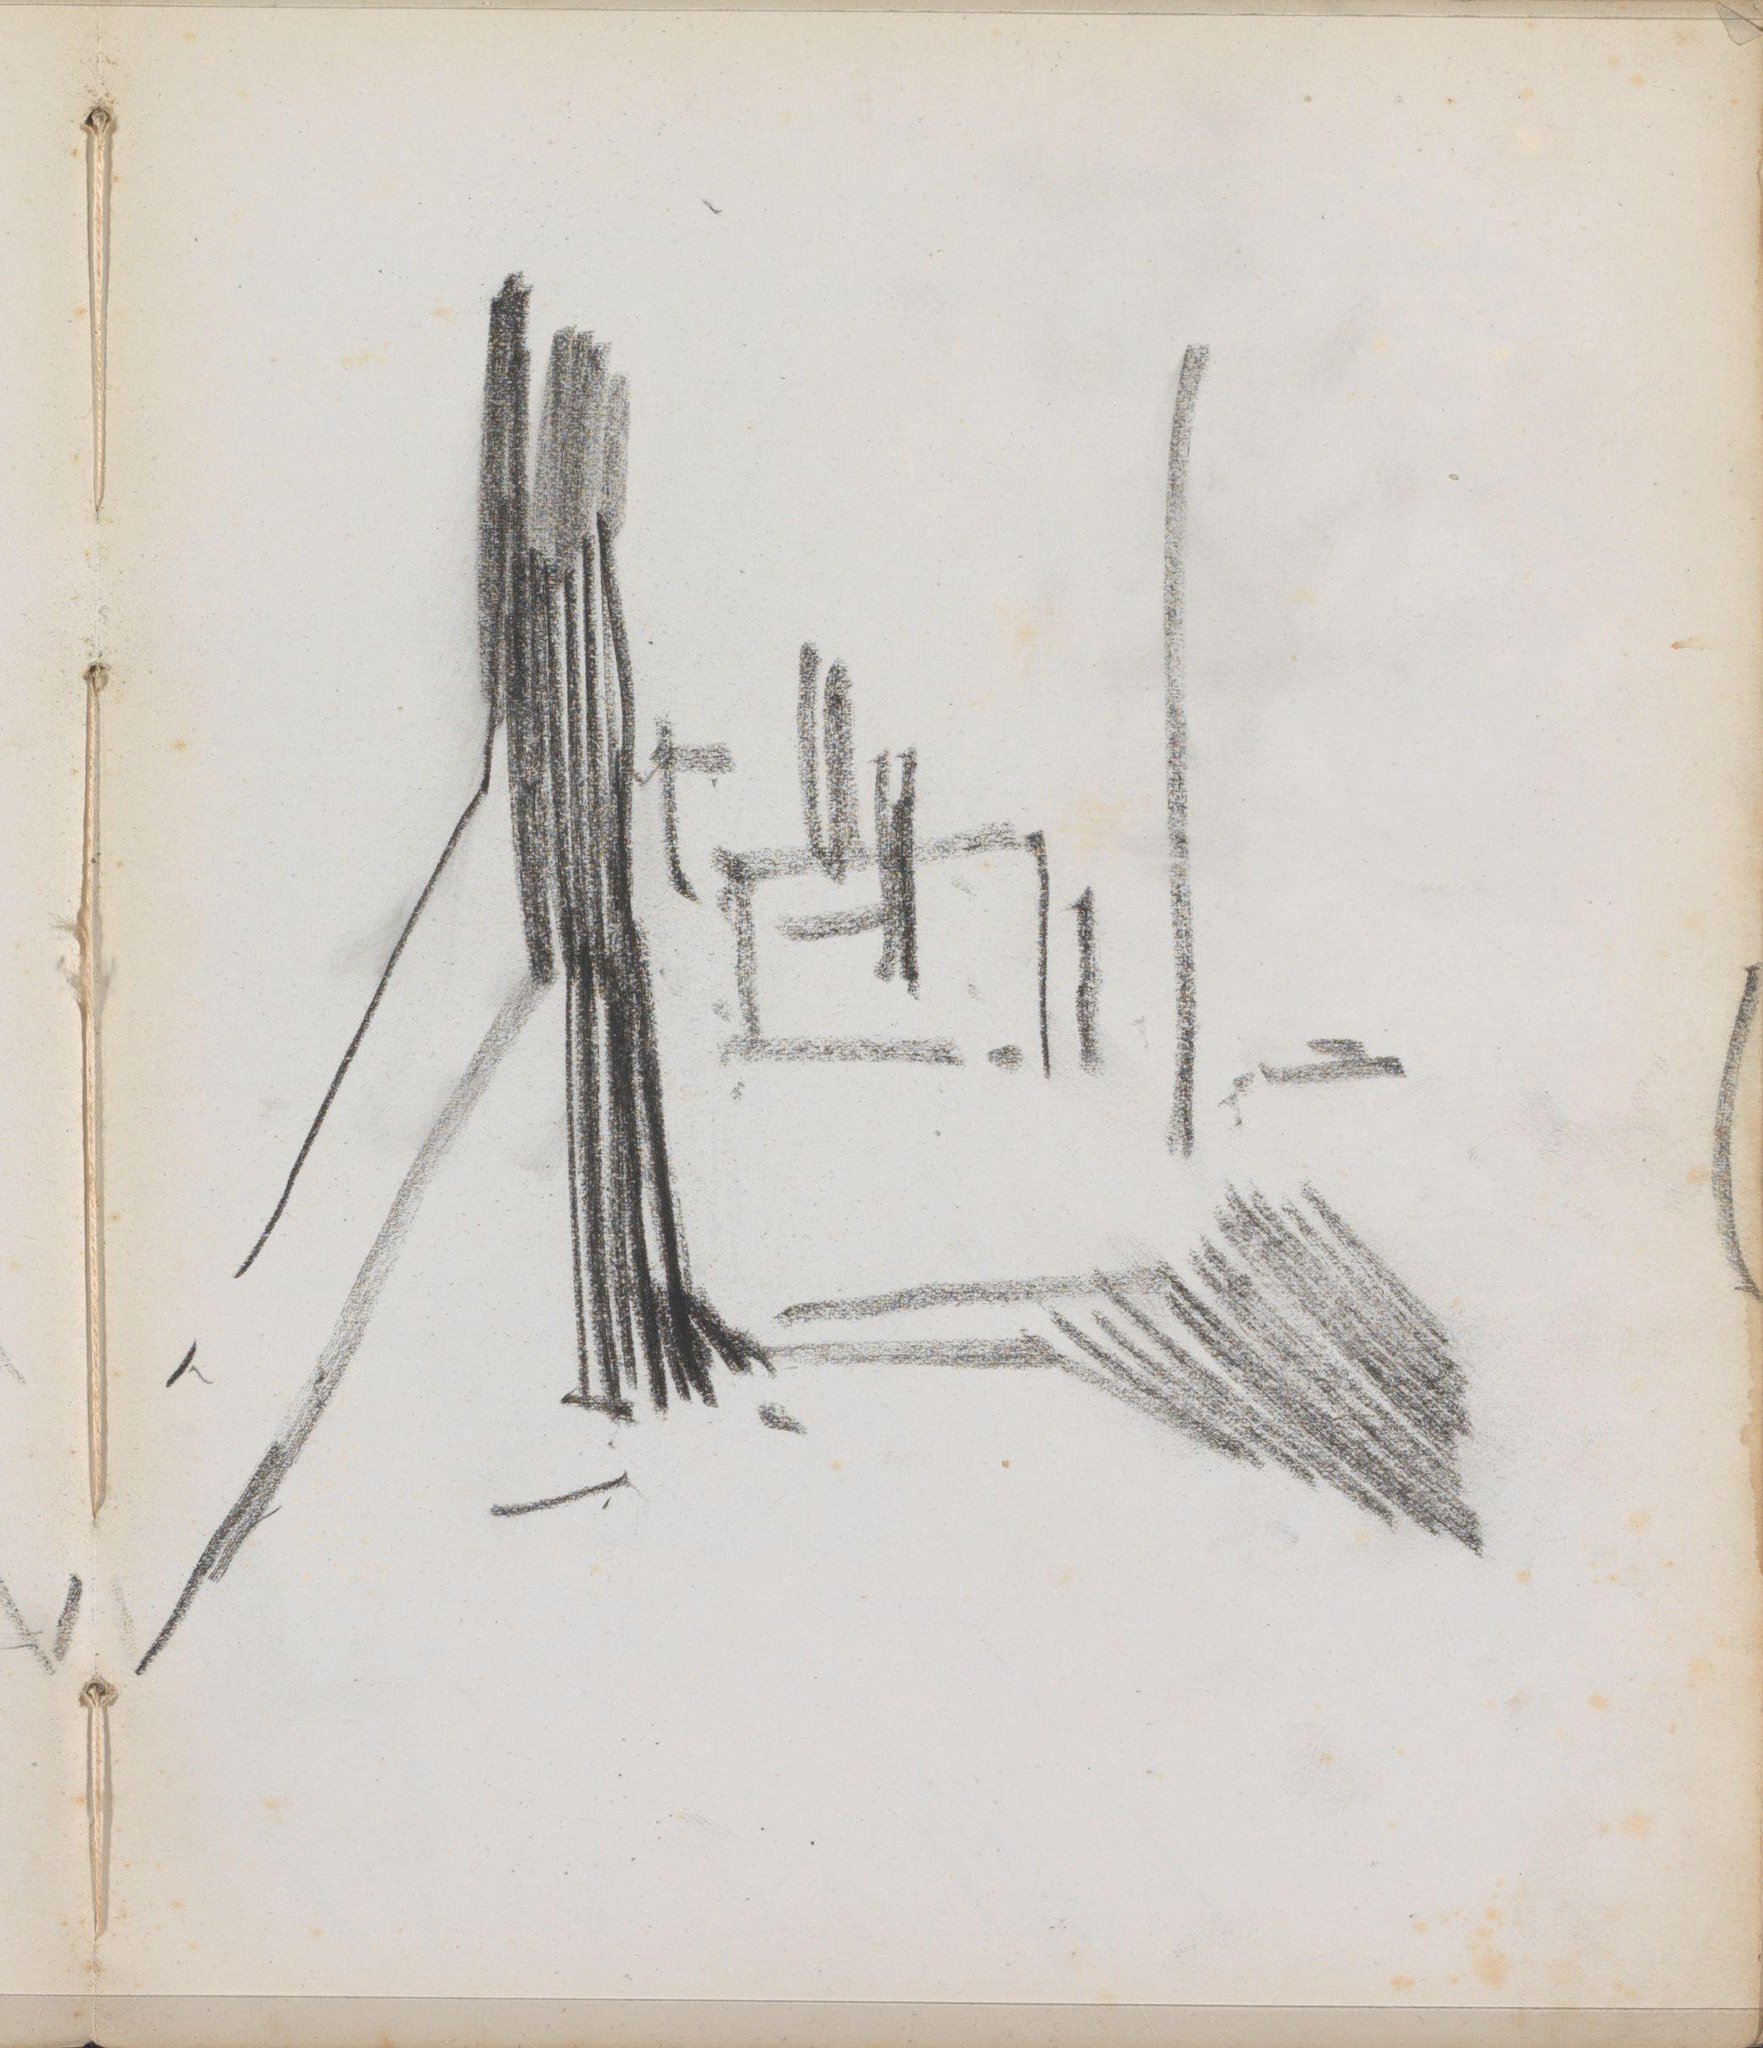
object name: sketchbook leaf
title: Studie, mogelijk van een doorgang of poort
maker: george hendrik breitner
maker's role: draughtsman, painter, print maker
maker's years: 1857-1923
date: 1880-1906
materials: chalk, paper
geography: netherlands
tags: gate, entrance, passage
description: Pagina 12 uit een schetsboek met 81 bladen.